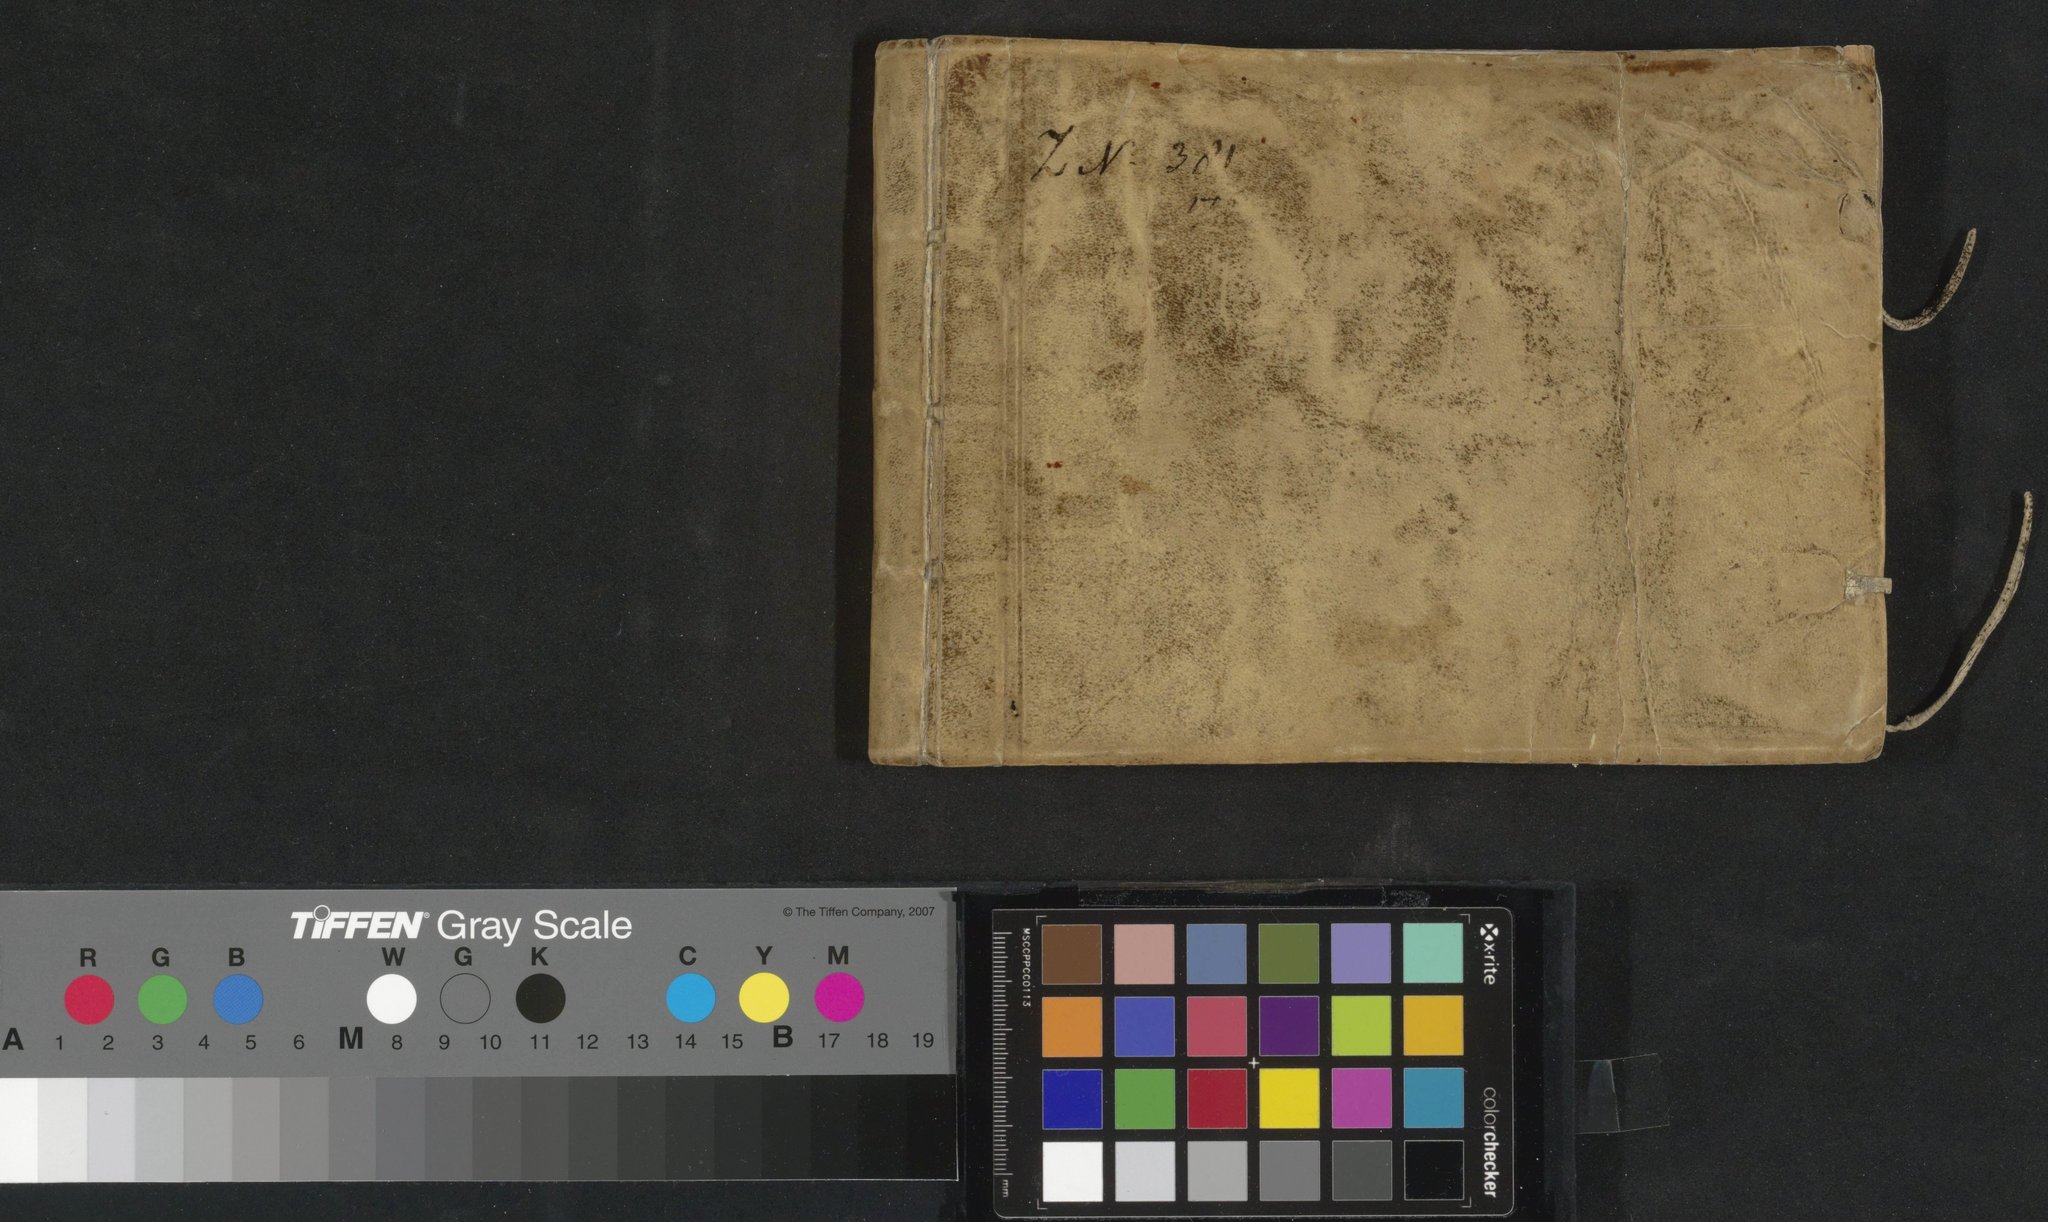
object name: sketchbook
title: Schetsboek met 55 bladen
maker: gerard ter borch (ii)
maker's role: draughtsman, painter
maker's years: 1617-1681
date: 1631-1635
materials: chalk, ink, paper, parchment, pencil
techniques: pen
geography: netherlands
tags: city-view, and landscape with man-made constructions, farm (building), ruin of a dwelling, house, castle, etc., haarlem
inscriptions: annotation: ‘G. ter Borch de oude/ ontbreekt/ 16-23 en 56/ aangekocht/ auctie Cremer (312)/ 1886 voor F217,35’, annotation: ‘klap’, annotation: ‘Z Nº 381 / 17 [?]’, collector's mark: Lugt 2228a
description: Bladen 16, 23 en 56 zijn uit het schetsboek gescheurd. Bladen 1(V), 3(V) t/m 34(V) en 36(V) t/m 53(V). zijn blanco. Het schetsboek is onregelmatig genummerd. Deze nummering is bij de invoer aangehouden.